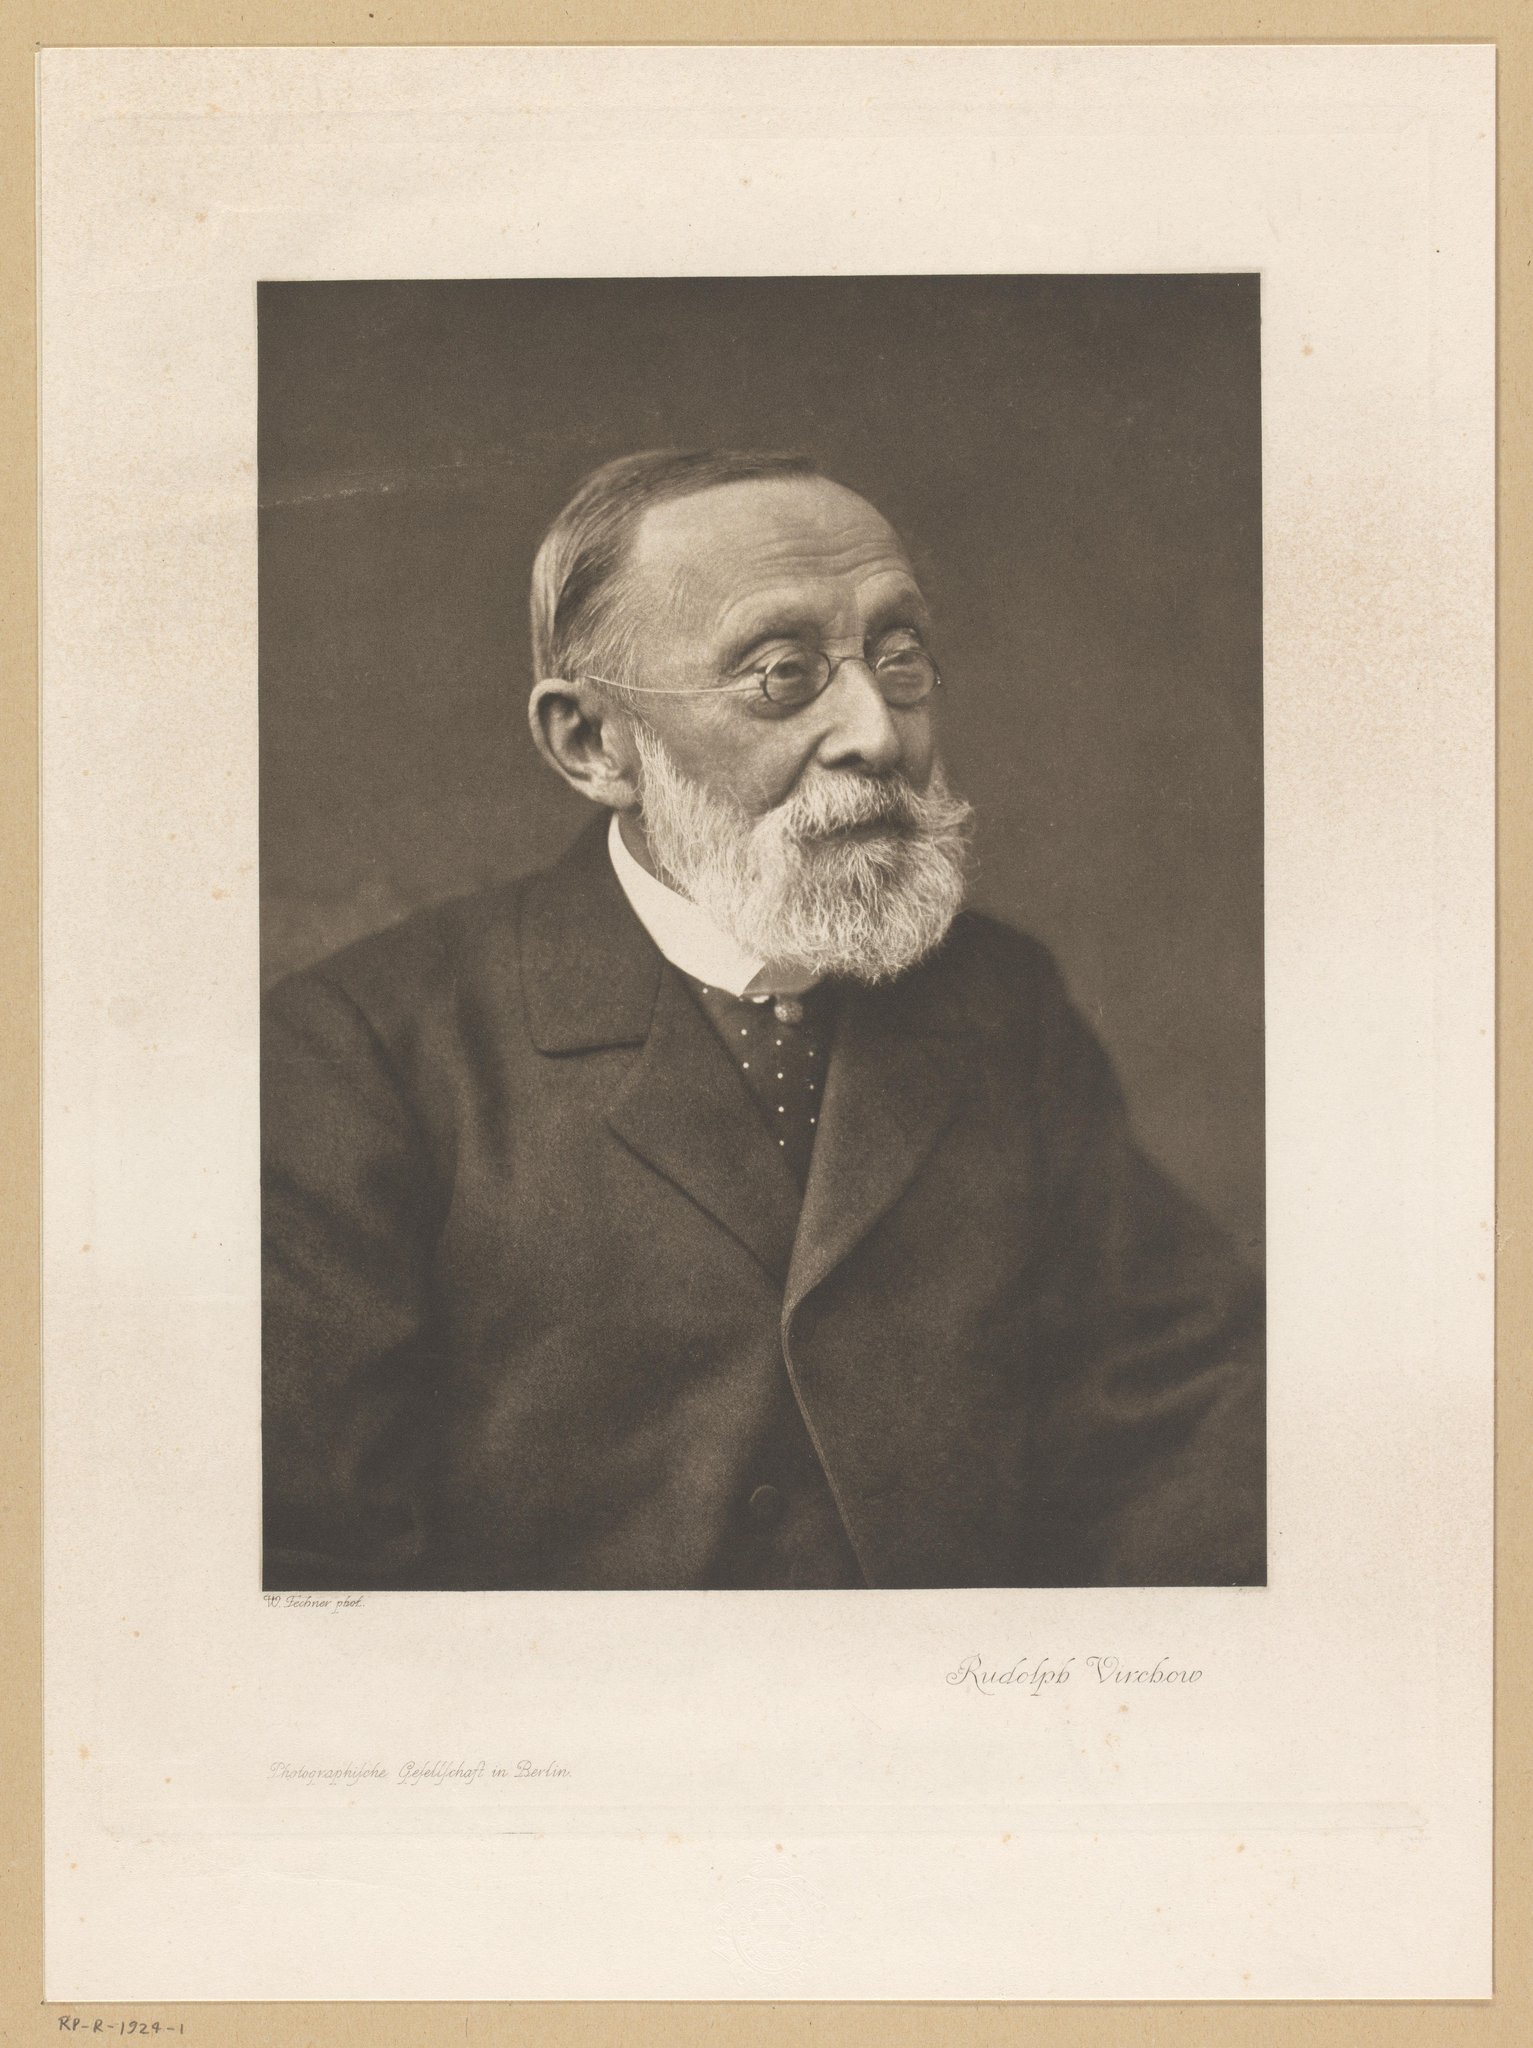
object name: photomechanical print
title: Portret van Rudolf Virchow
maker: wilhelm fechner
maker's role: painter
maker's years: 1835-1909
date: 1880-1900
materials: paper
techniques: photoaquatint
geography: berlin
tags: berlin, scholar, philosopher, historical persons, old man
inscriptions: collector's mark: Lugt 2233